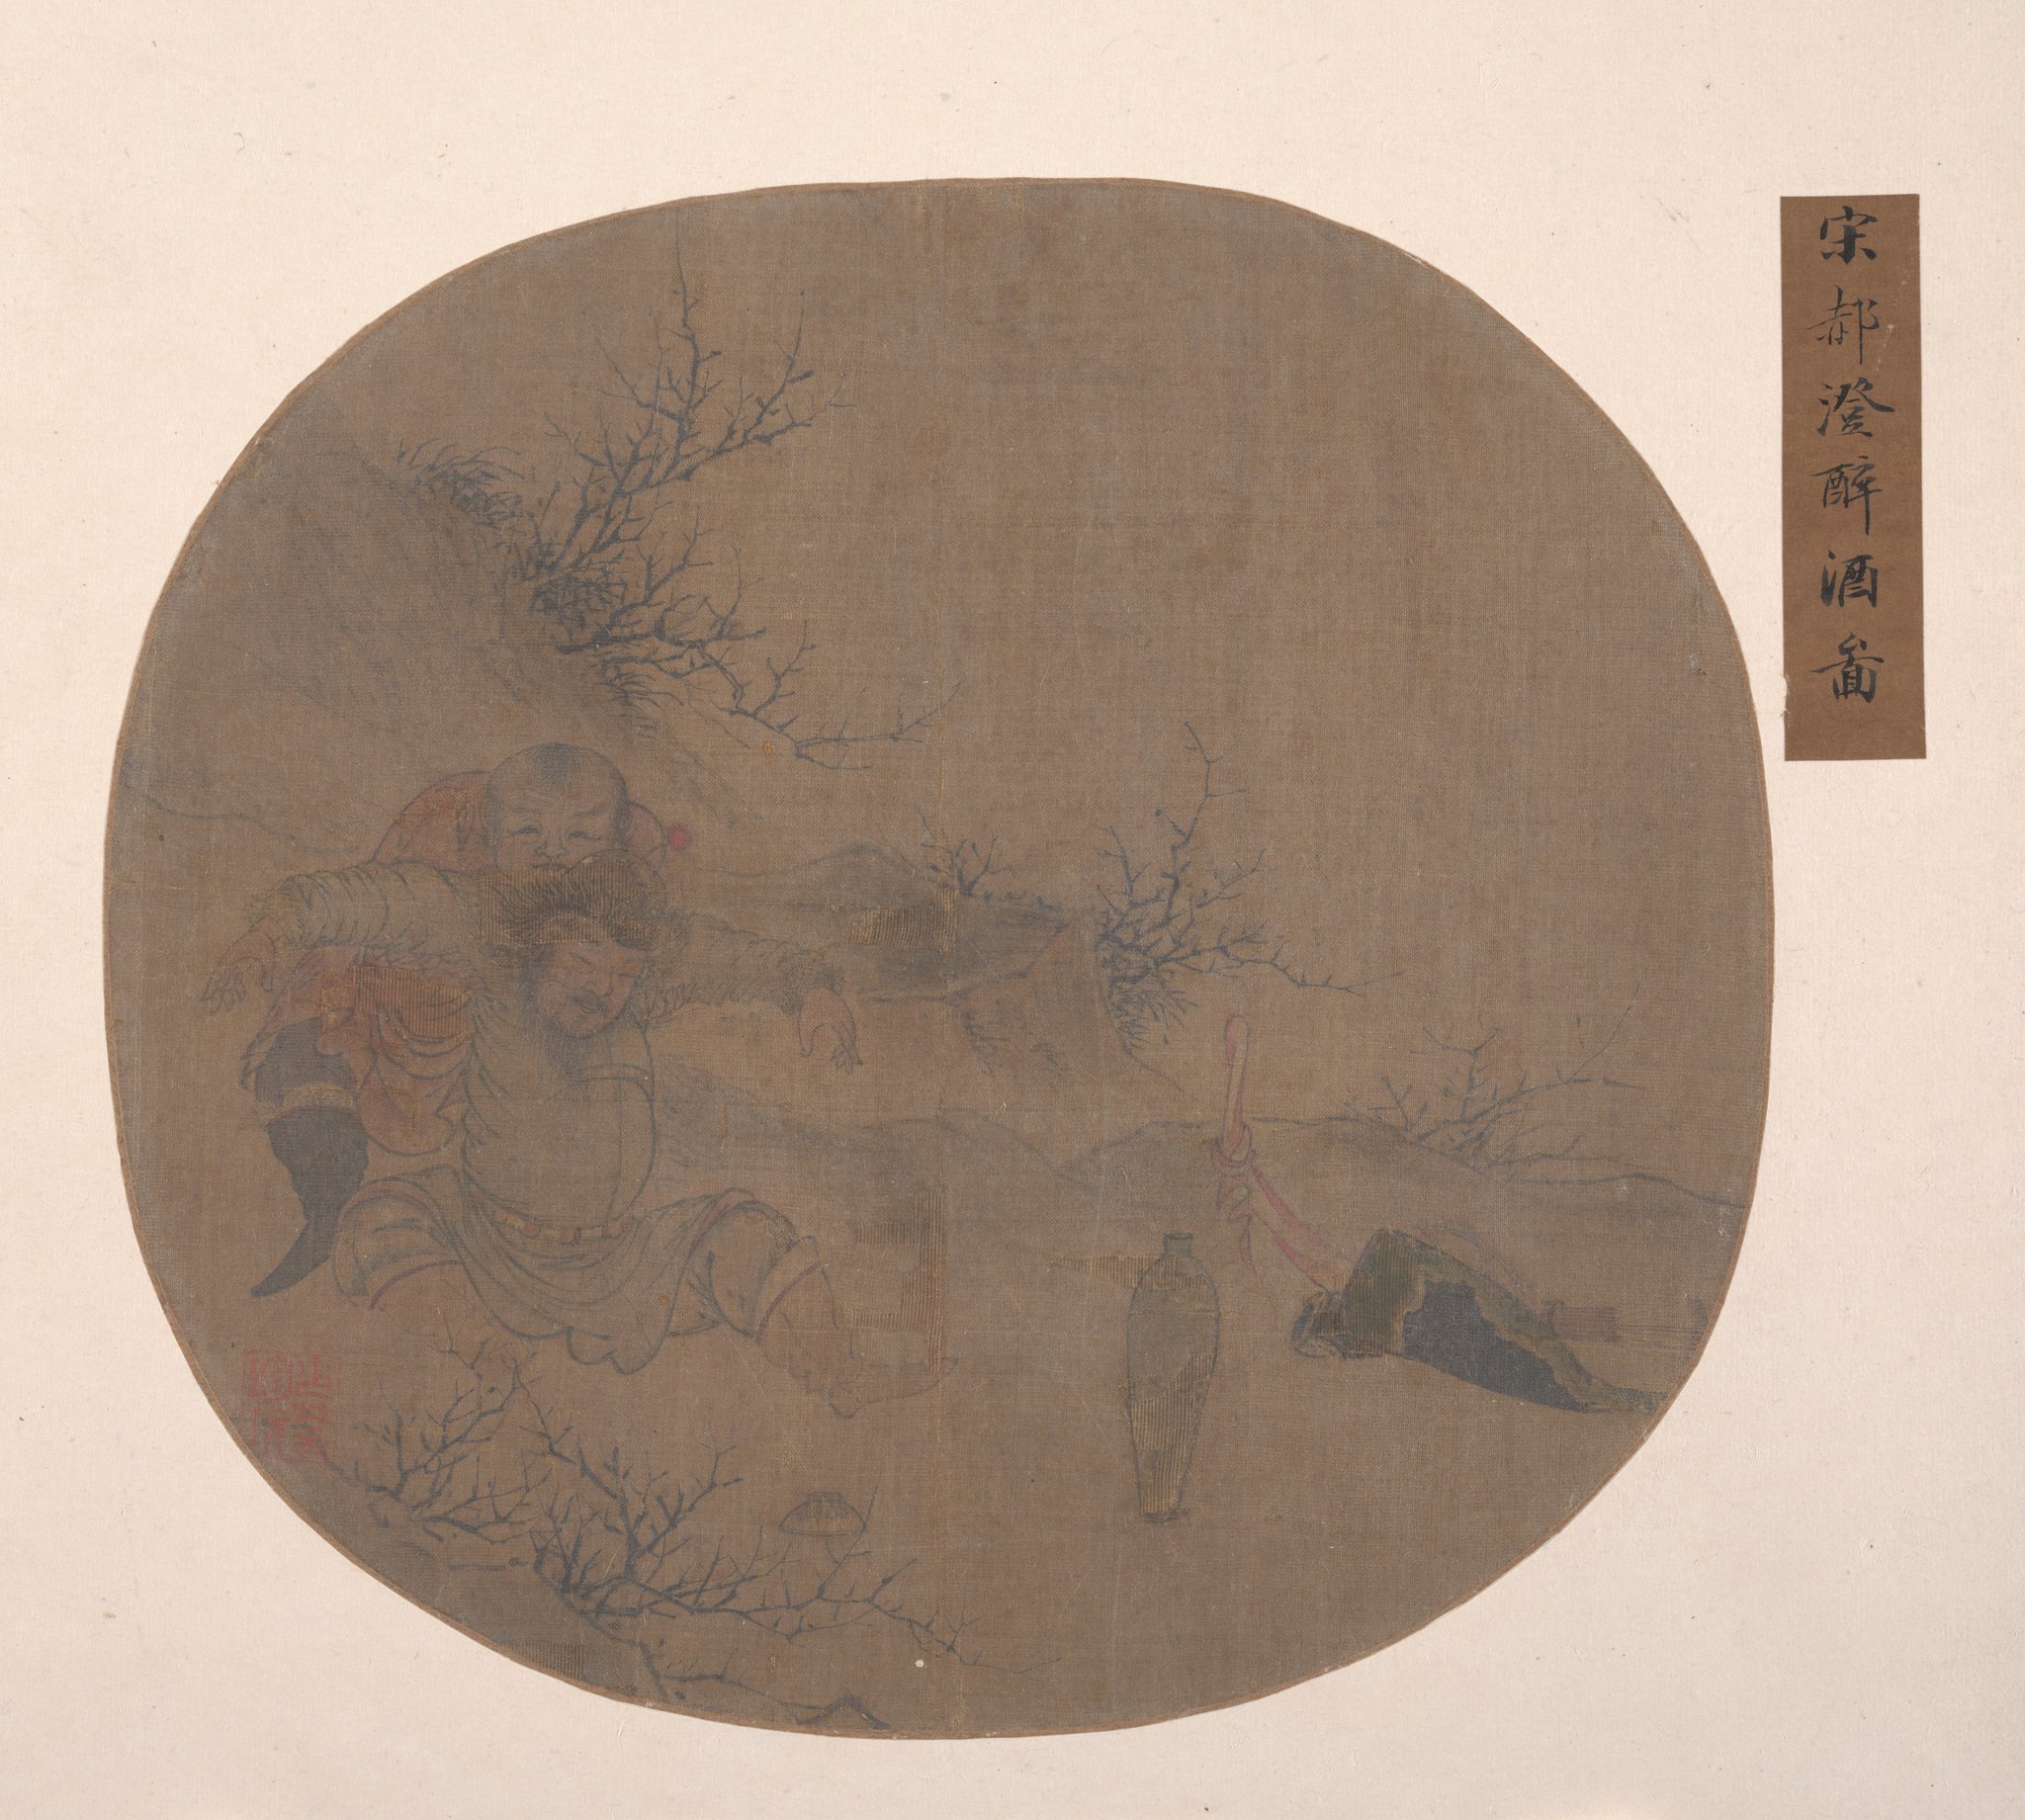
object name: fan mounted a an album leaf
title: Landscape with Drunken General and Servant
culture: chinese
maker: unidentified artist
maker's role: artist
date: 1000-1035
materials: ink, silk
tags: drunkenness,men,servants